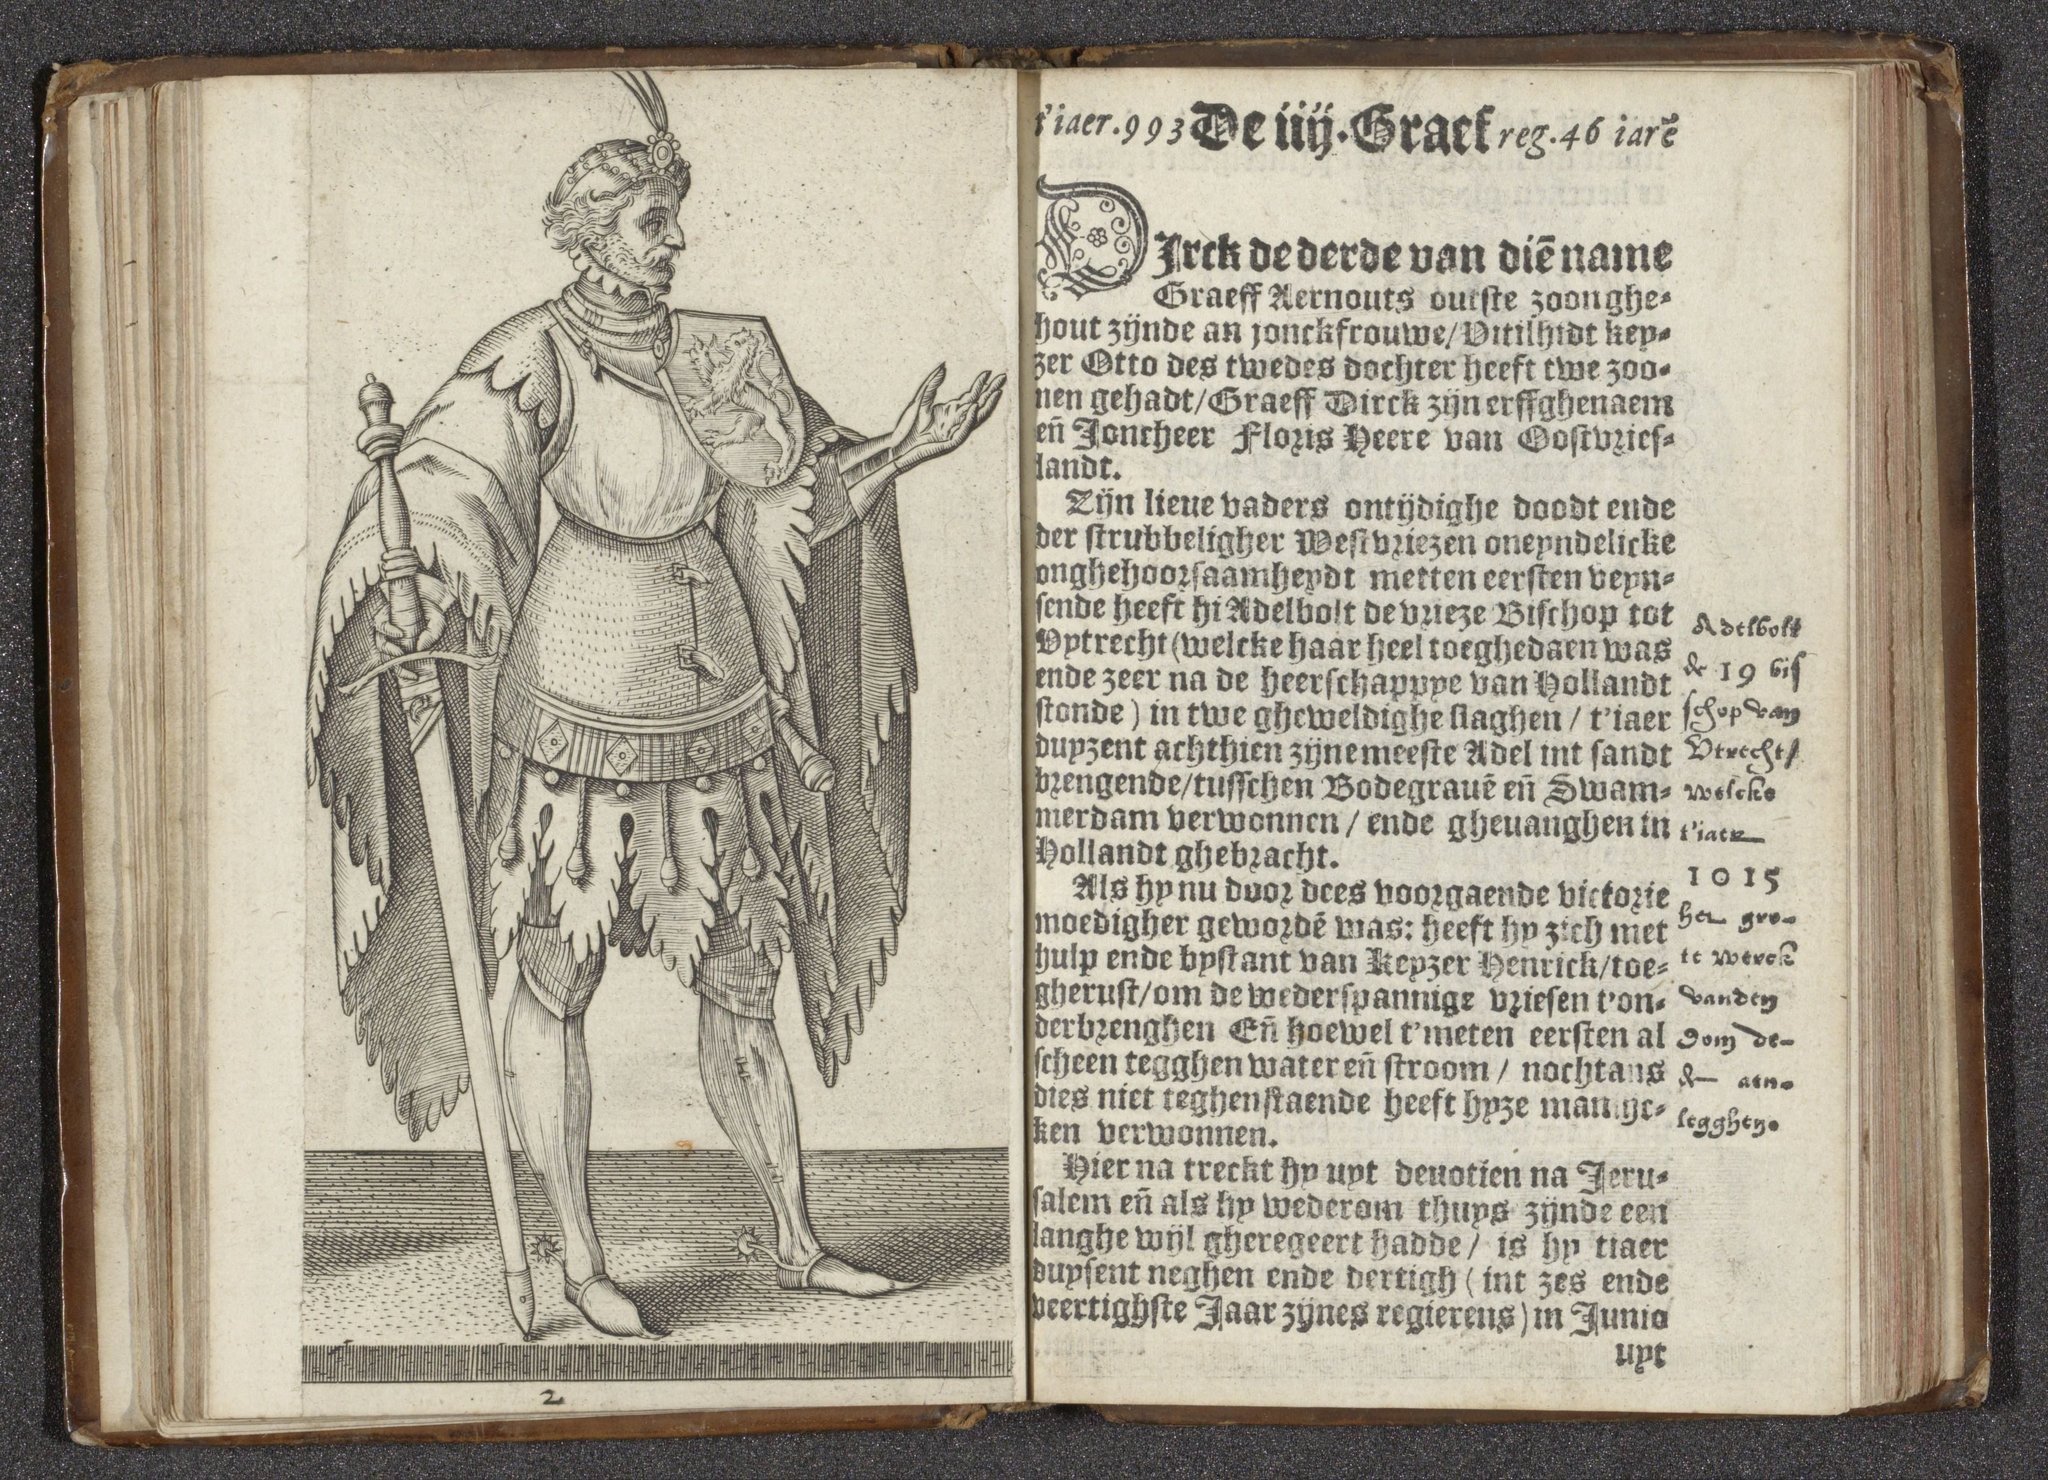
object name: album leaf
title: Graaf Dirk III van Holland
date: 1586-1587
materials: paper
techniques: engraving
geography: haarlem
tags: historical persons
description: Graaf Dirk III, ten voeten uit en naar rechts gekeerd. Het zwaard in zijn hand rust met de punt op de grond. Op het wapenschild een klimmende leeuw. Onderaan genummerd 2. De prent maakt deel uit van een boek met beschrijvingen en voorstellingen van de graven van Holland, Zeeland en Friesland.